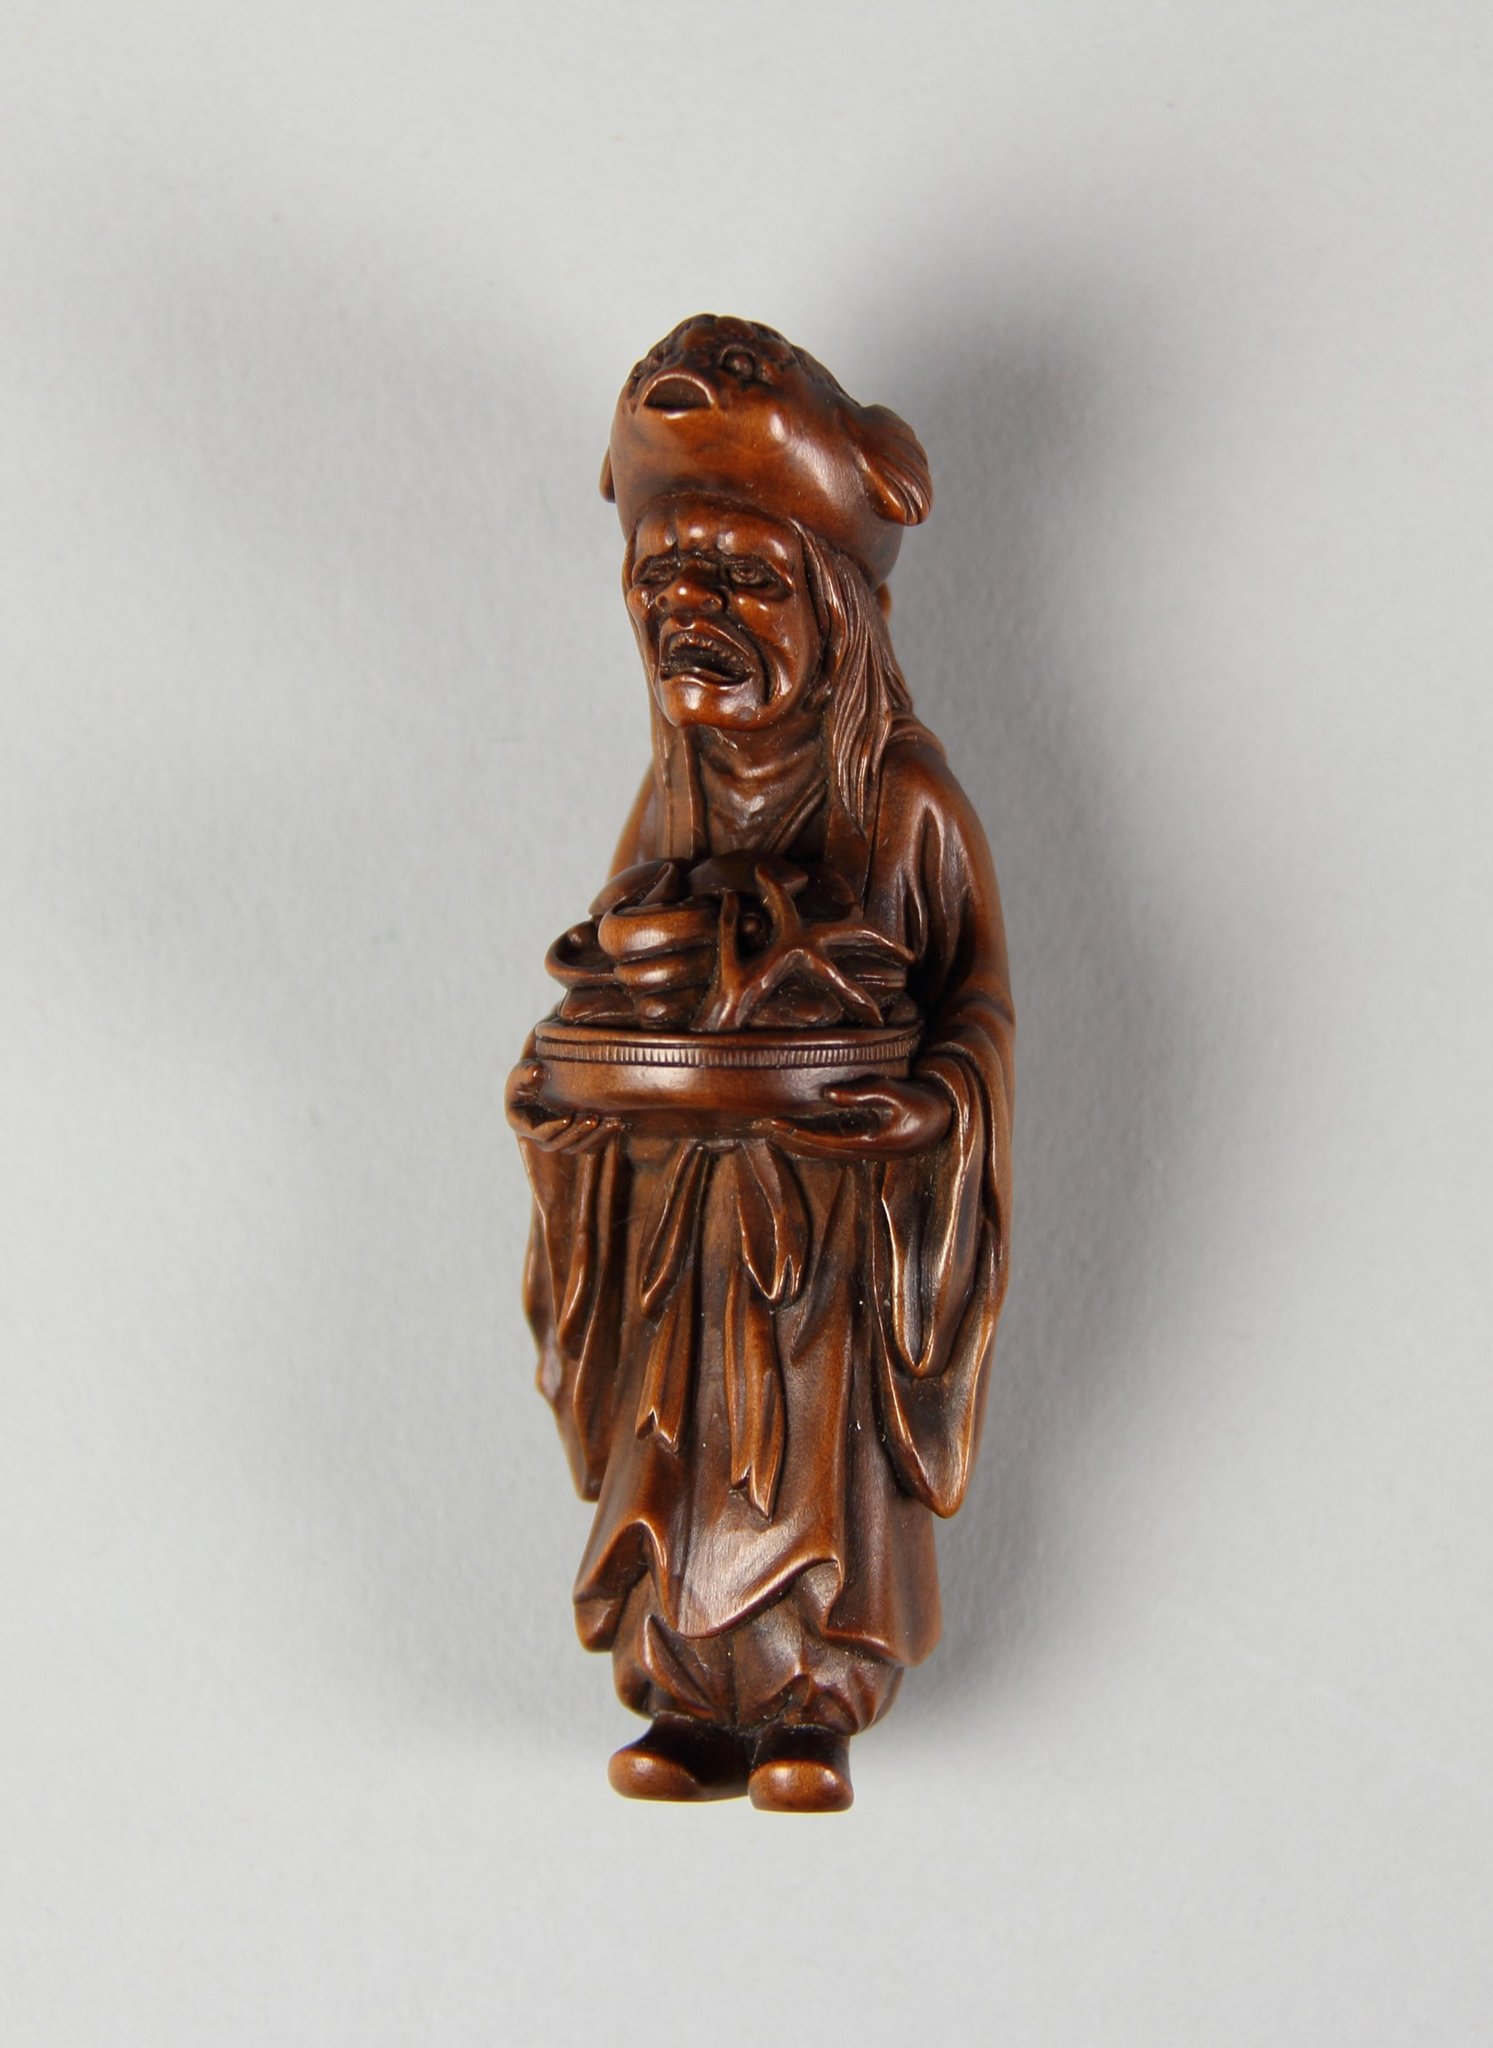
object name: netsuke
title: Netsuke: Daughter of Ryujin, the Dragon King of the Sea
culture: japanese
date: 1801-1900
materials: wood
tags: human figures,fish